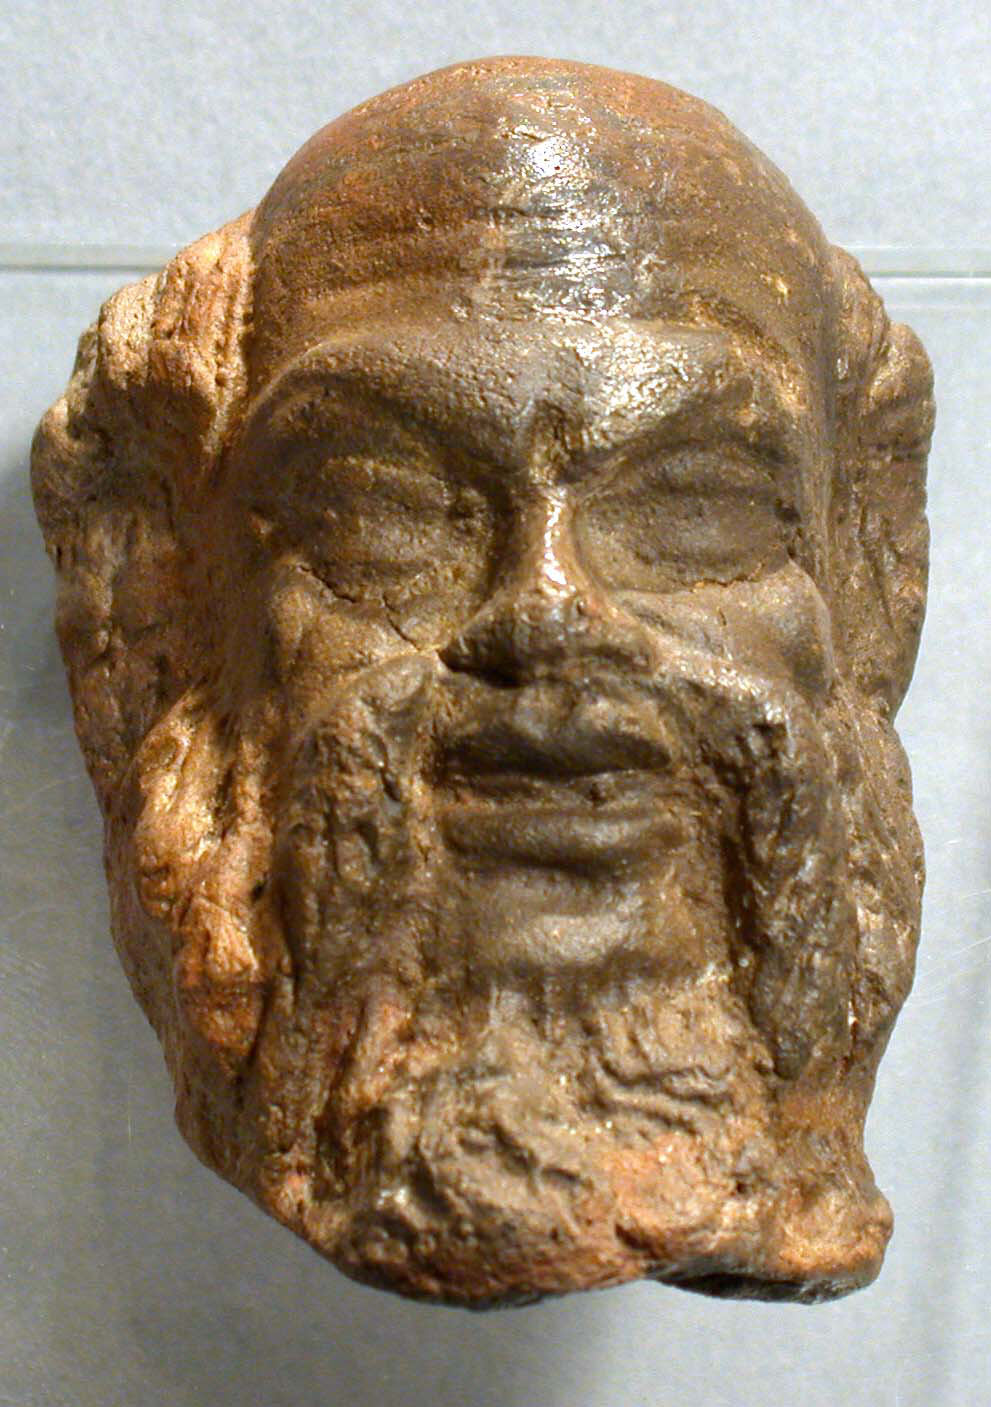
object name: head of silenus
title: Terracotta head of Silenus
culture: greek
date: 300-201 BCE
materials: terracotta